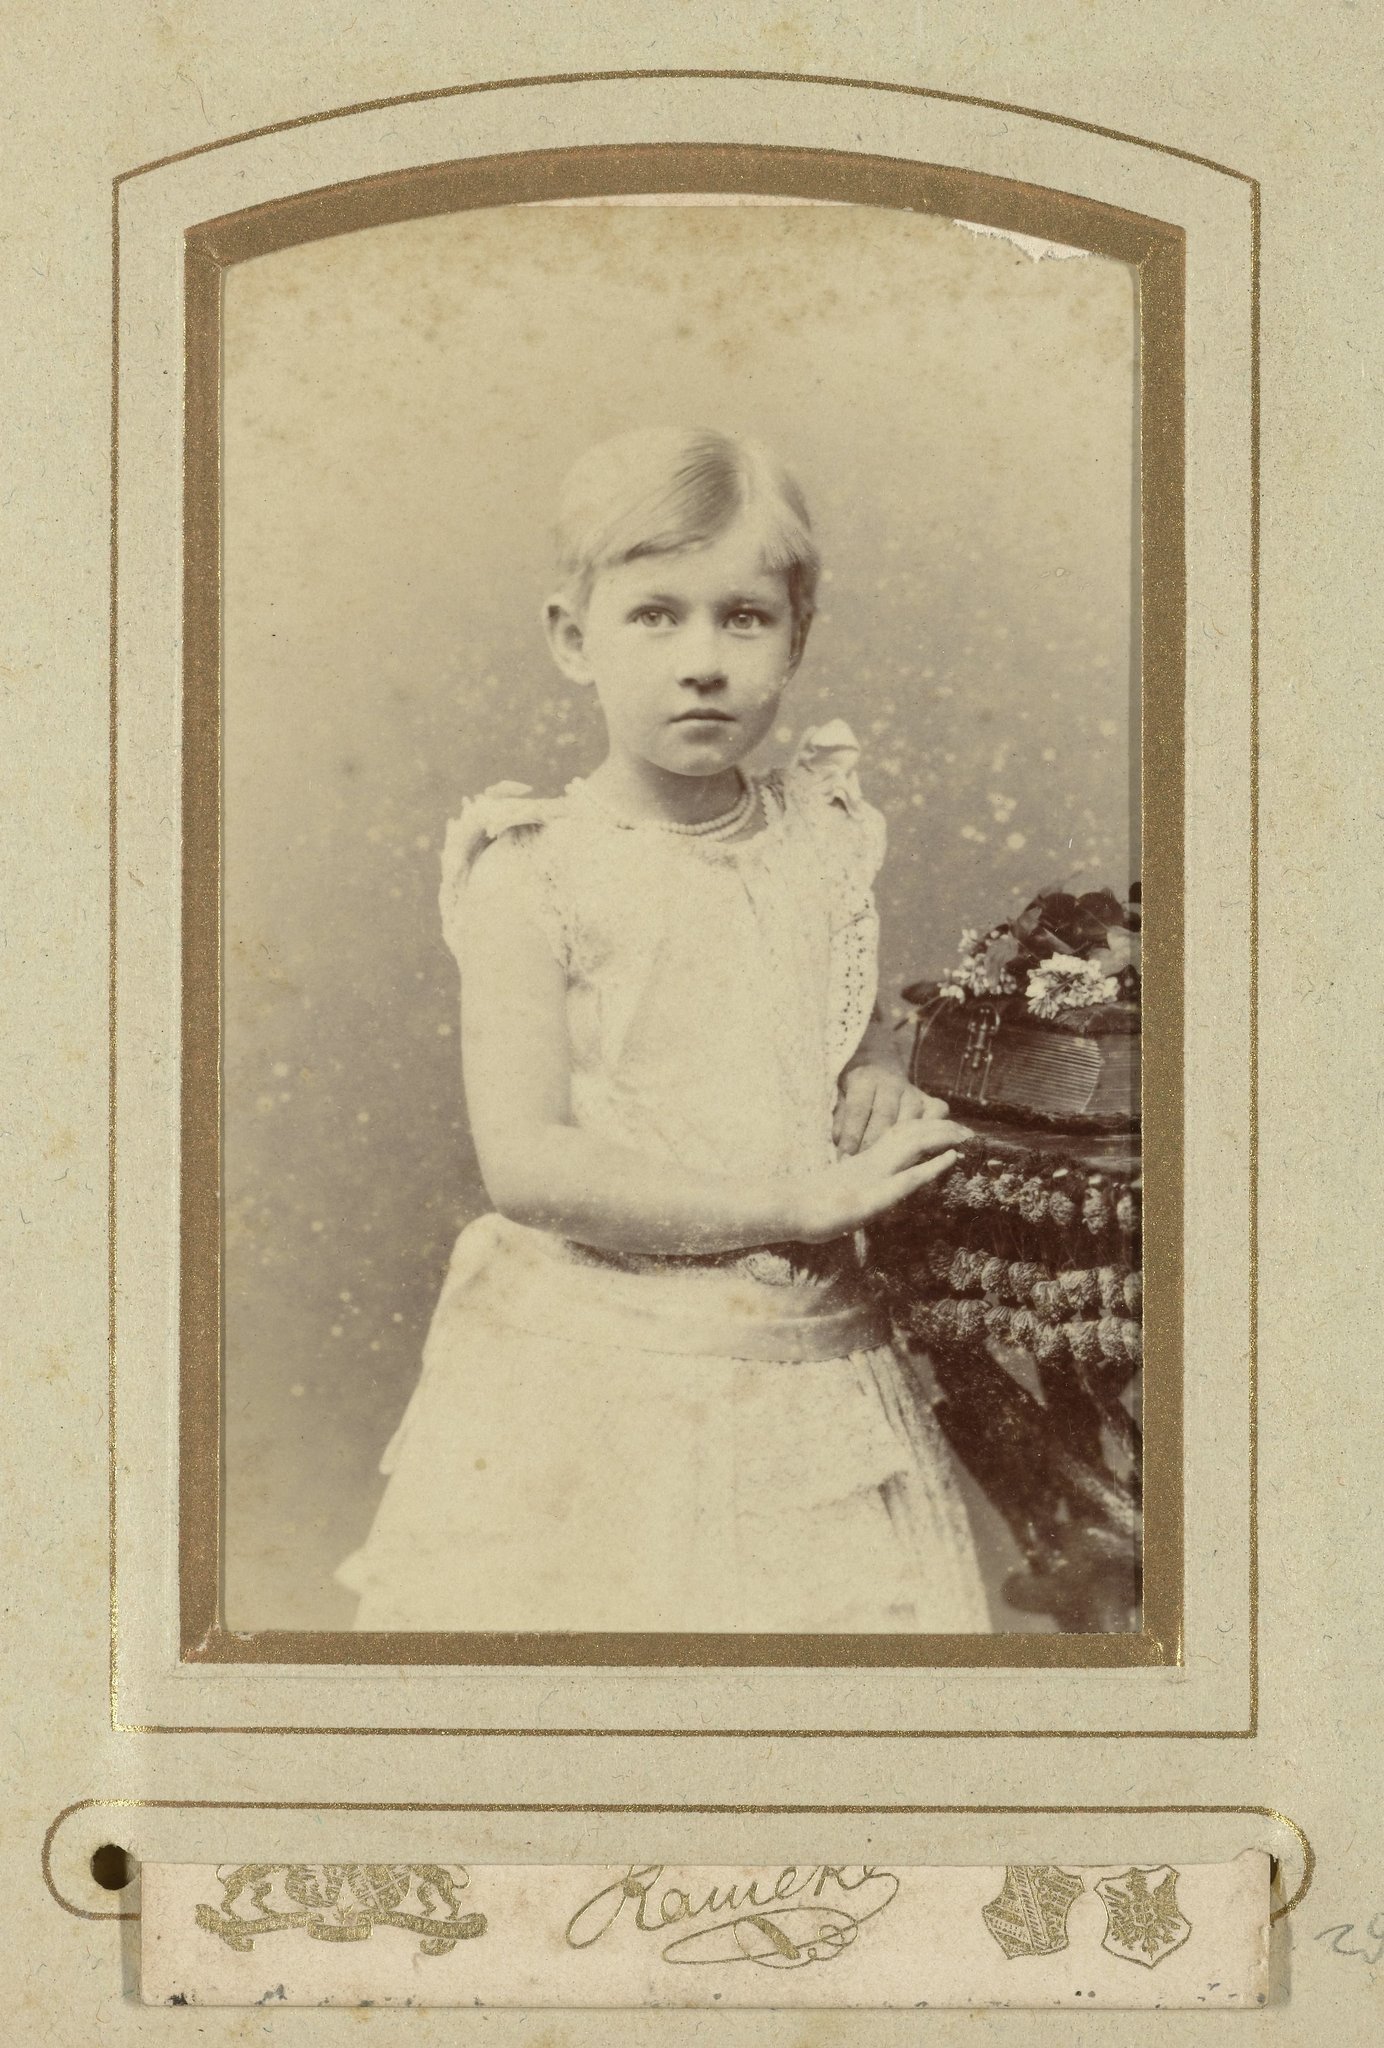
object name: photograph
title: Portret van An Kessler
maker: richard kameke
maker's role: fotograaf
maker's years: 1847-1898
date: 1890-1898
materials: paper, photographic support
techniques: photography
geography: the hague